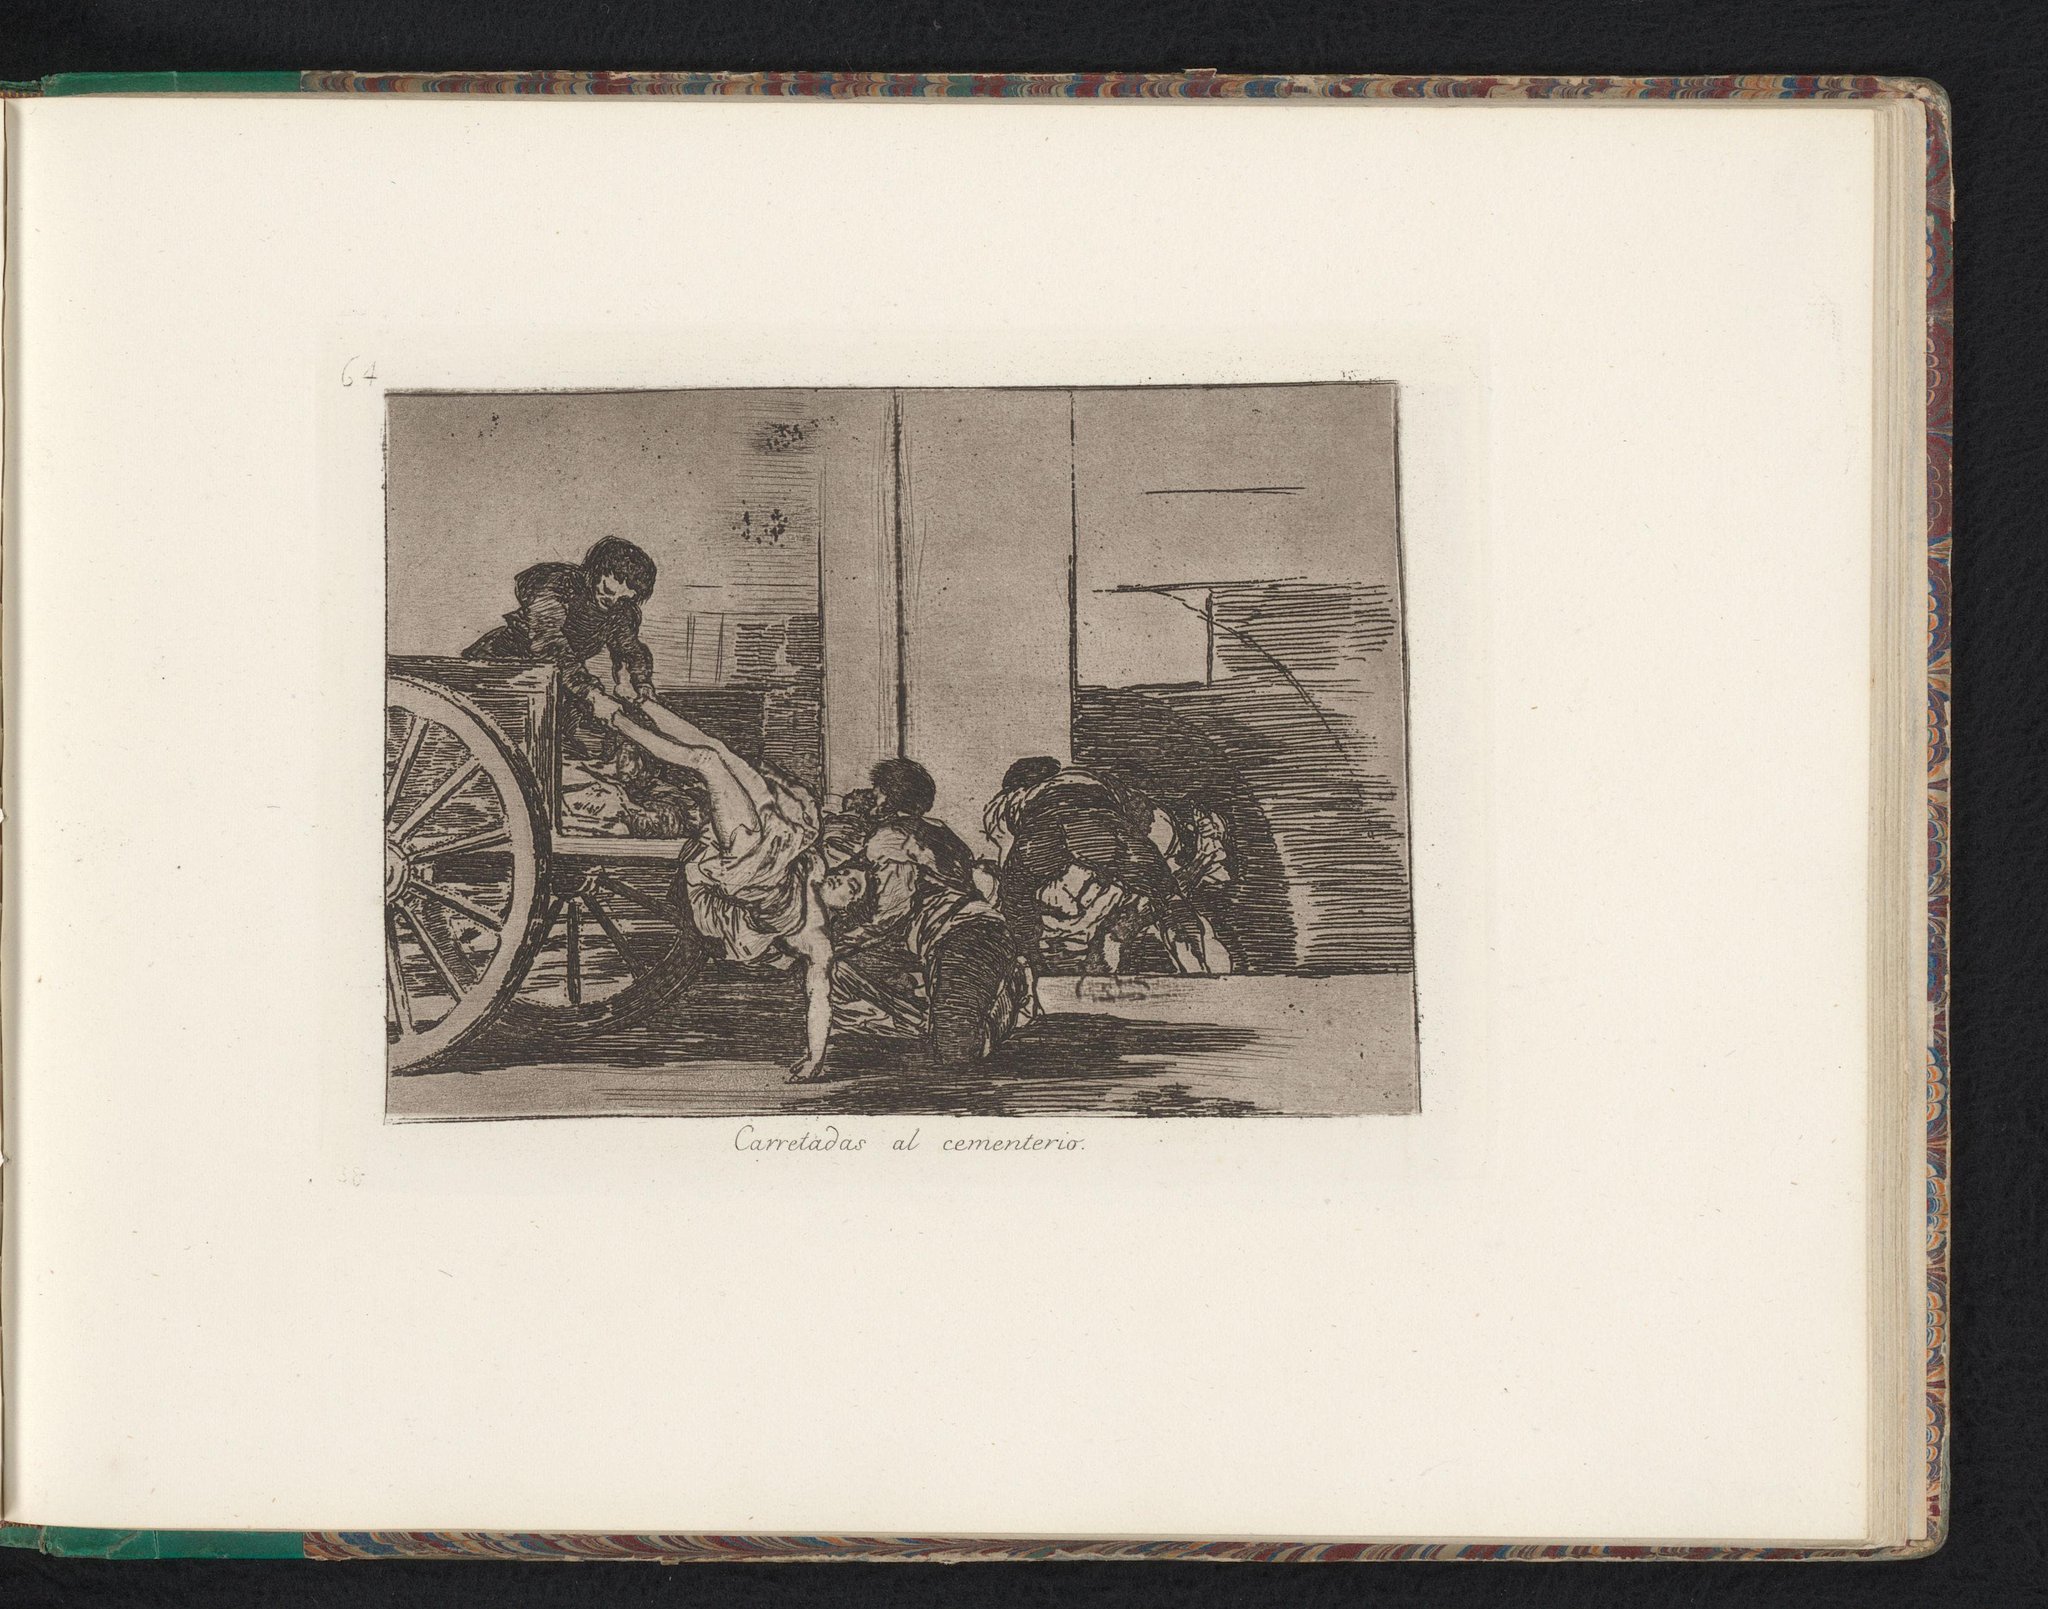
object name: print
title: Lijken worden van een kar gedragen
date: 1810-1820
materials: paper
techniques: aquatint, drypoint, engraving, etching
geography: madrid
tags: transport of the sick, wounded and dead by vehicle, horrors of war, churchyard, cemetery, spain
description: Deze prent maakt deel uit van een album.